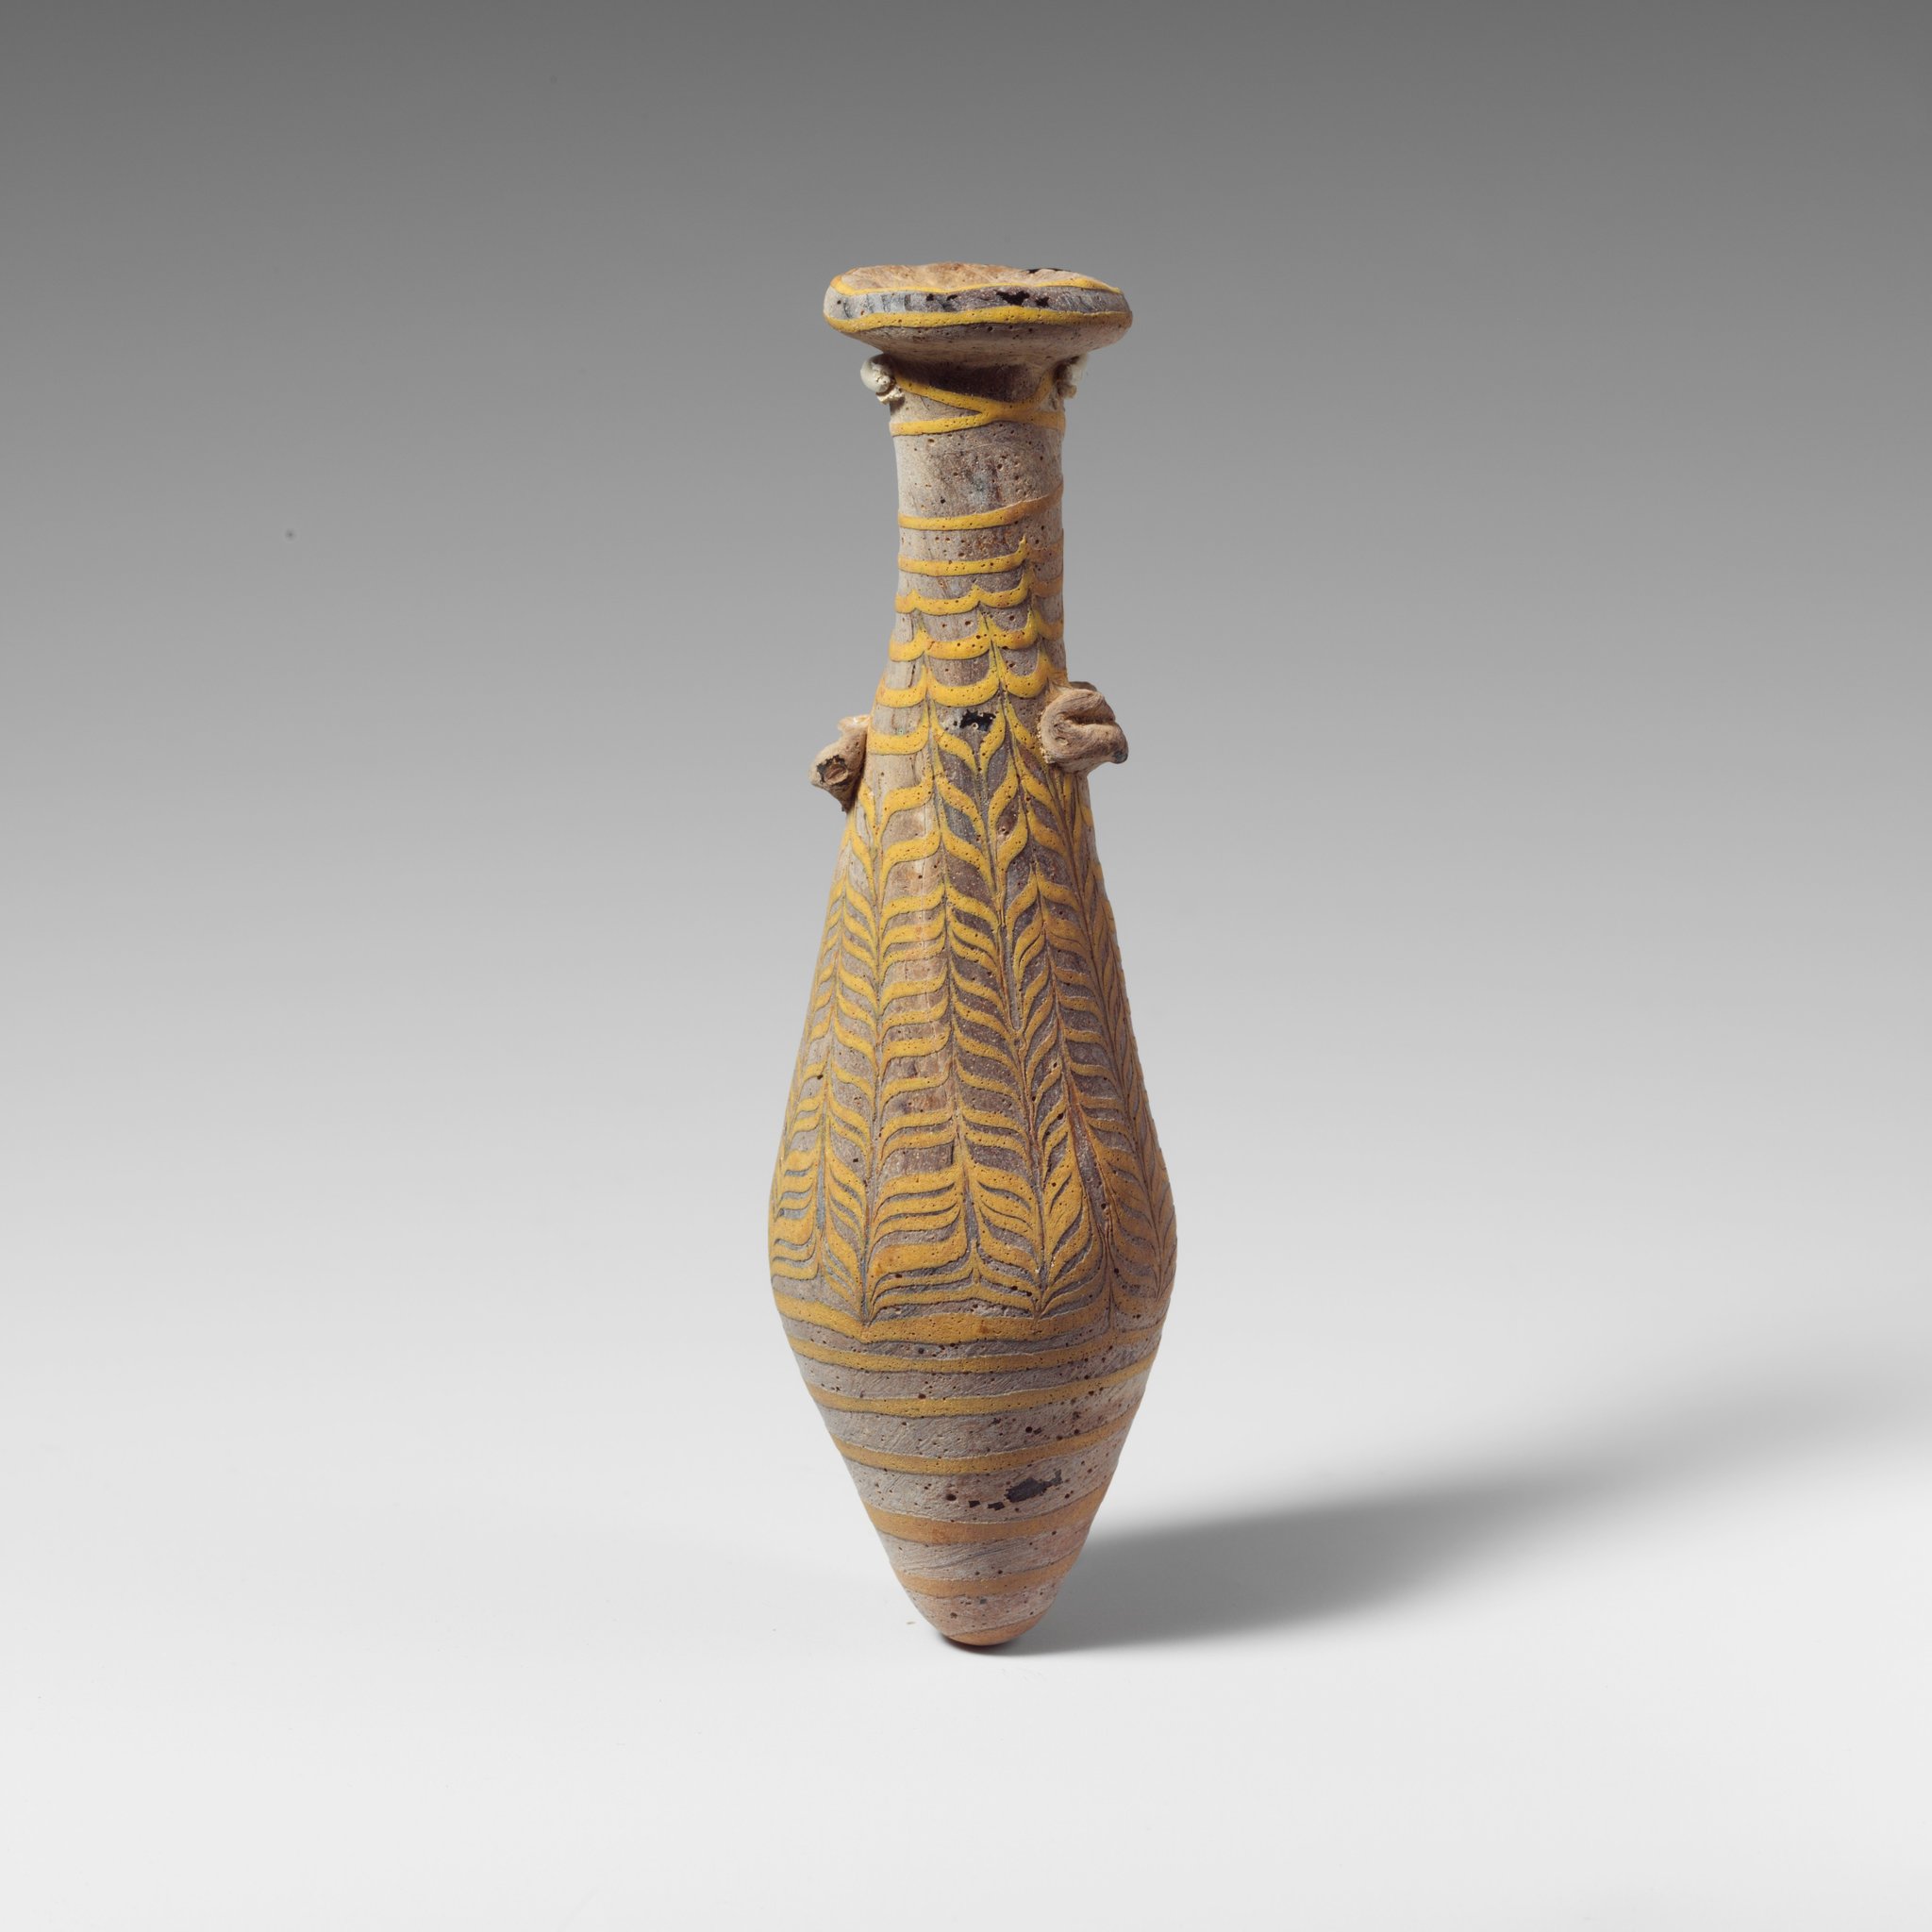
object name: alabastron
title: Glass alabastron (perfume bottle)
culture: greek, eastern mediterranean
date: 200-35 BCE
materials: glass